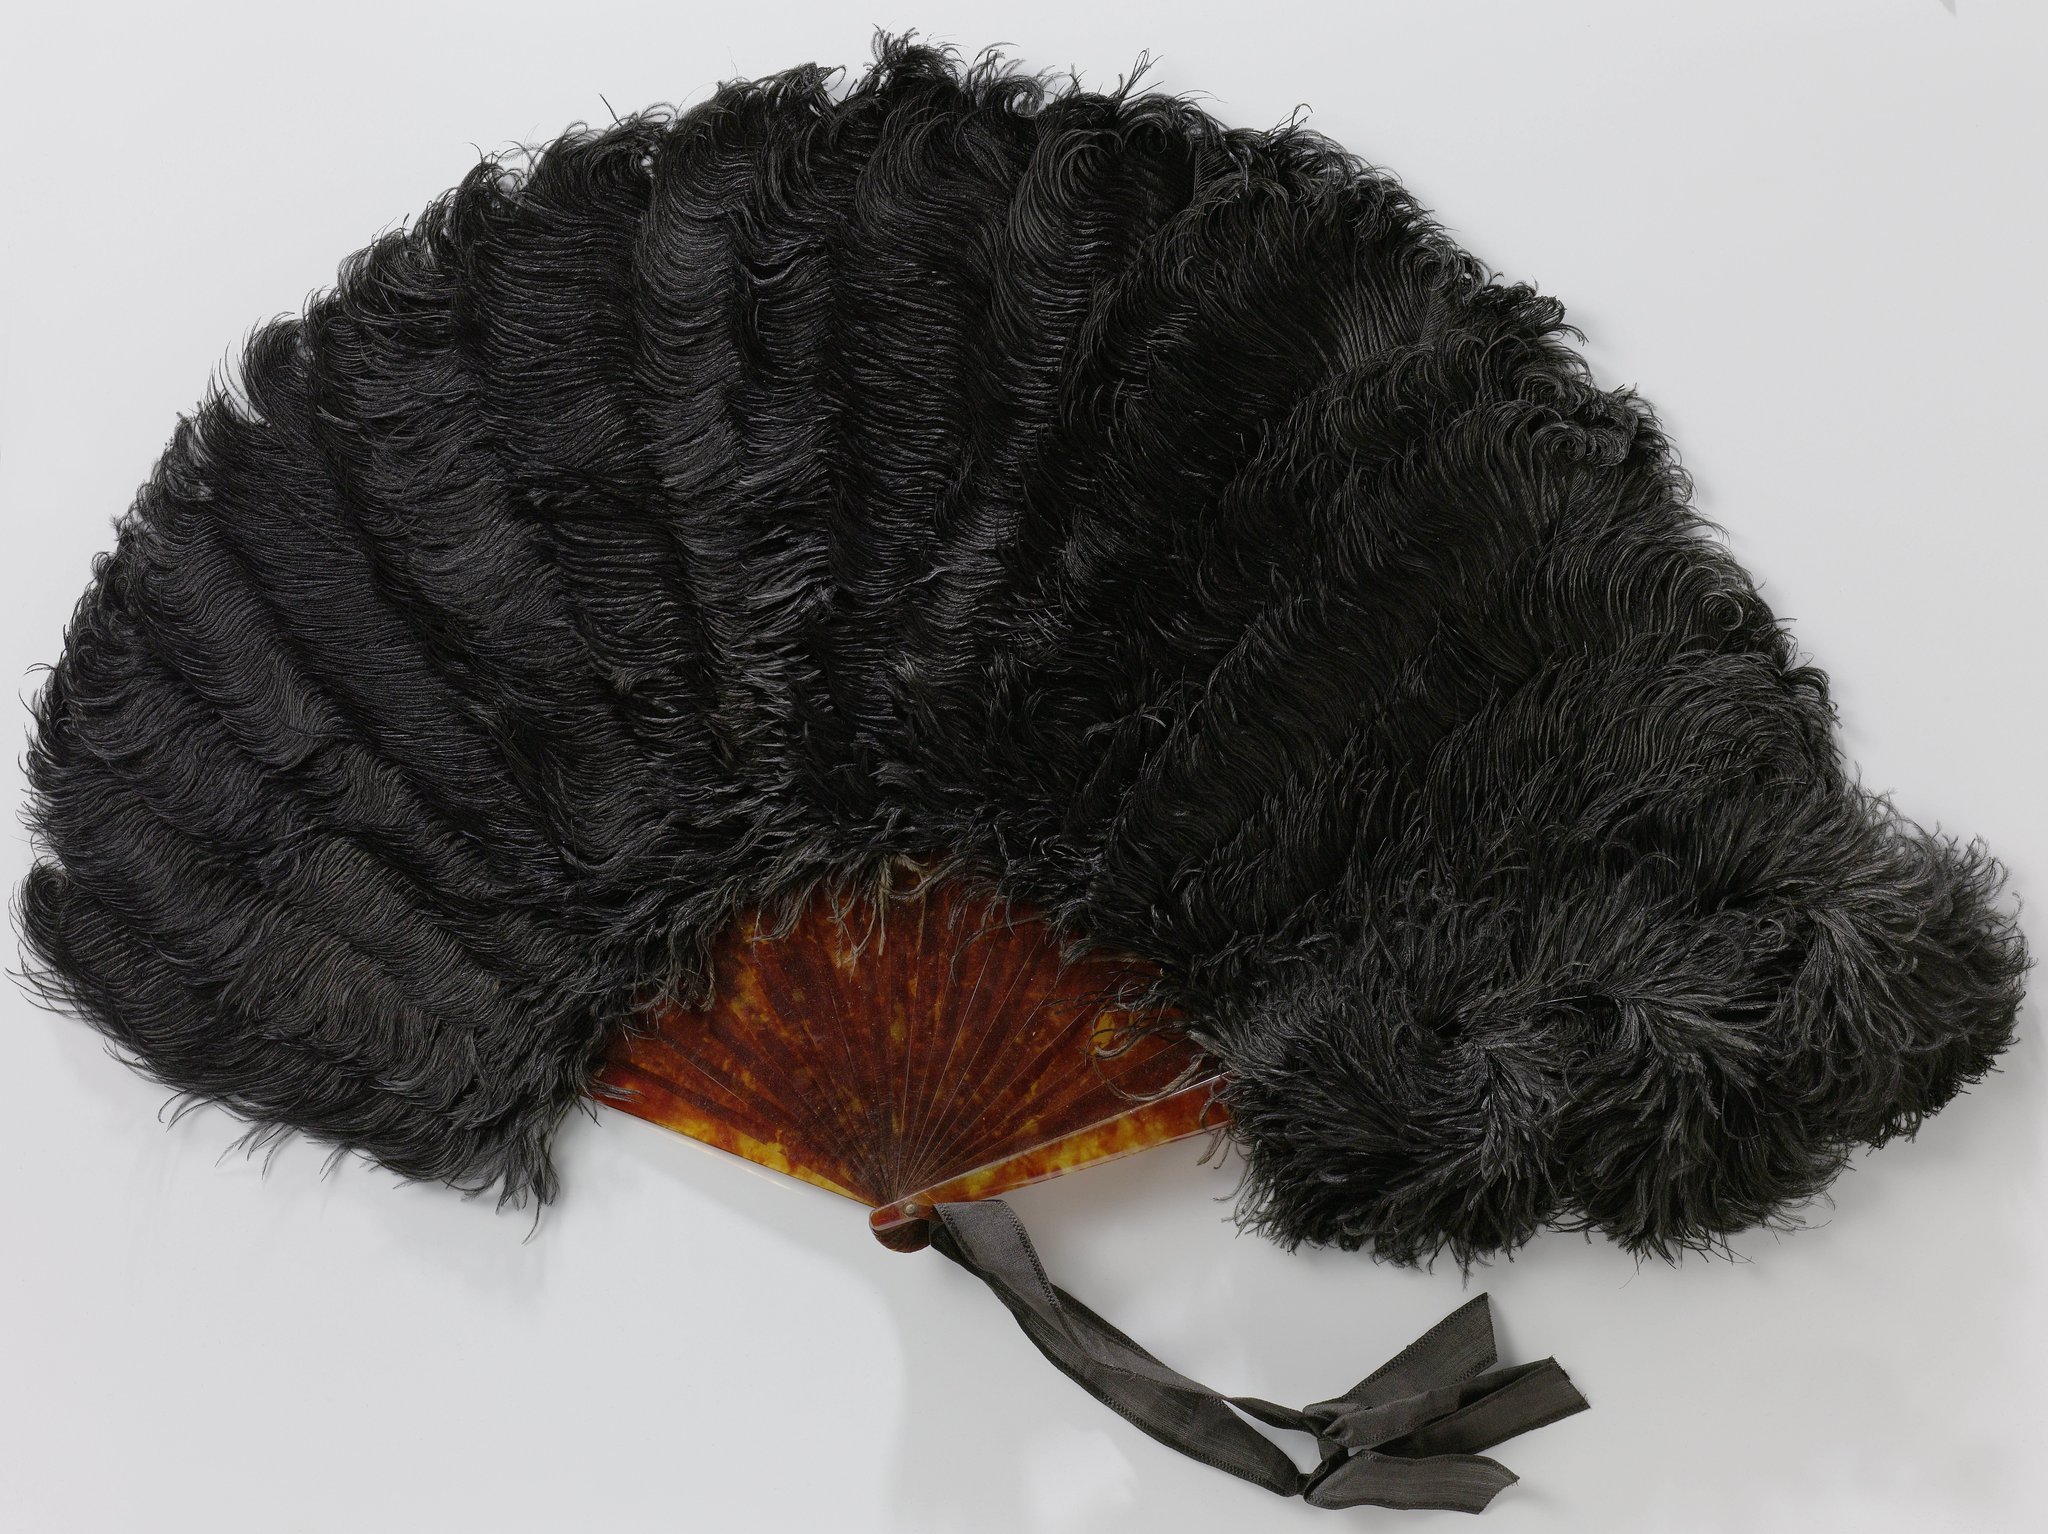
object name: vouwwaaier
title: Vouwwaaier met zwarte struisvogelveren op montuur van onversierd schildpad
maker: Anonymous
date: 1905-1915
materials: shell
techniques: cutting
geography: netherlands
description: Vouwwaaier met zwarte struisvogelveren, op rechterbuitenbeen een extra grote veer. Het montuur is van onversierd schildpad (?) en heeft twintig aaneengesloten benen. De waaierring is van schildpad waaraan een zwart lint.